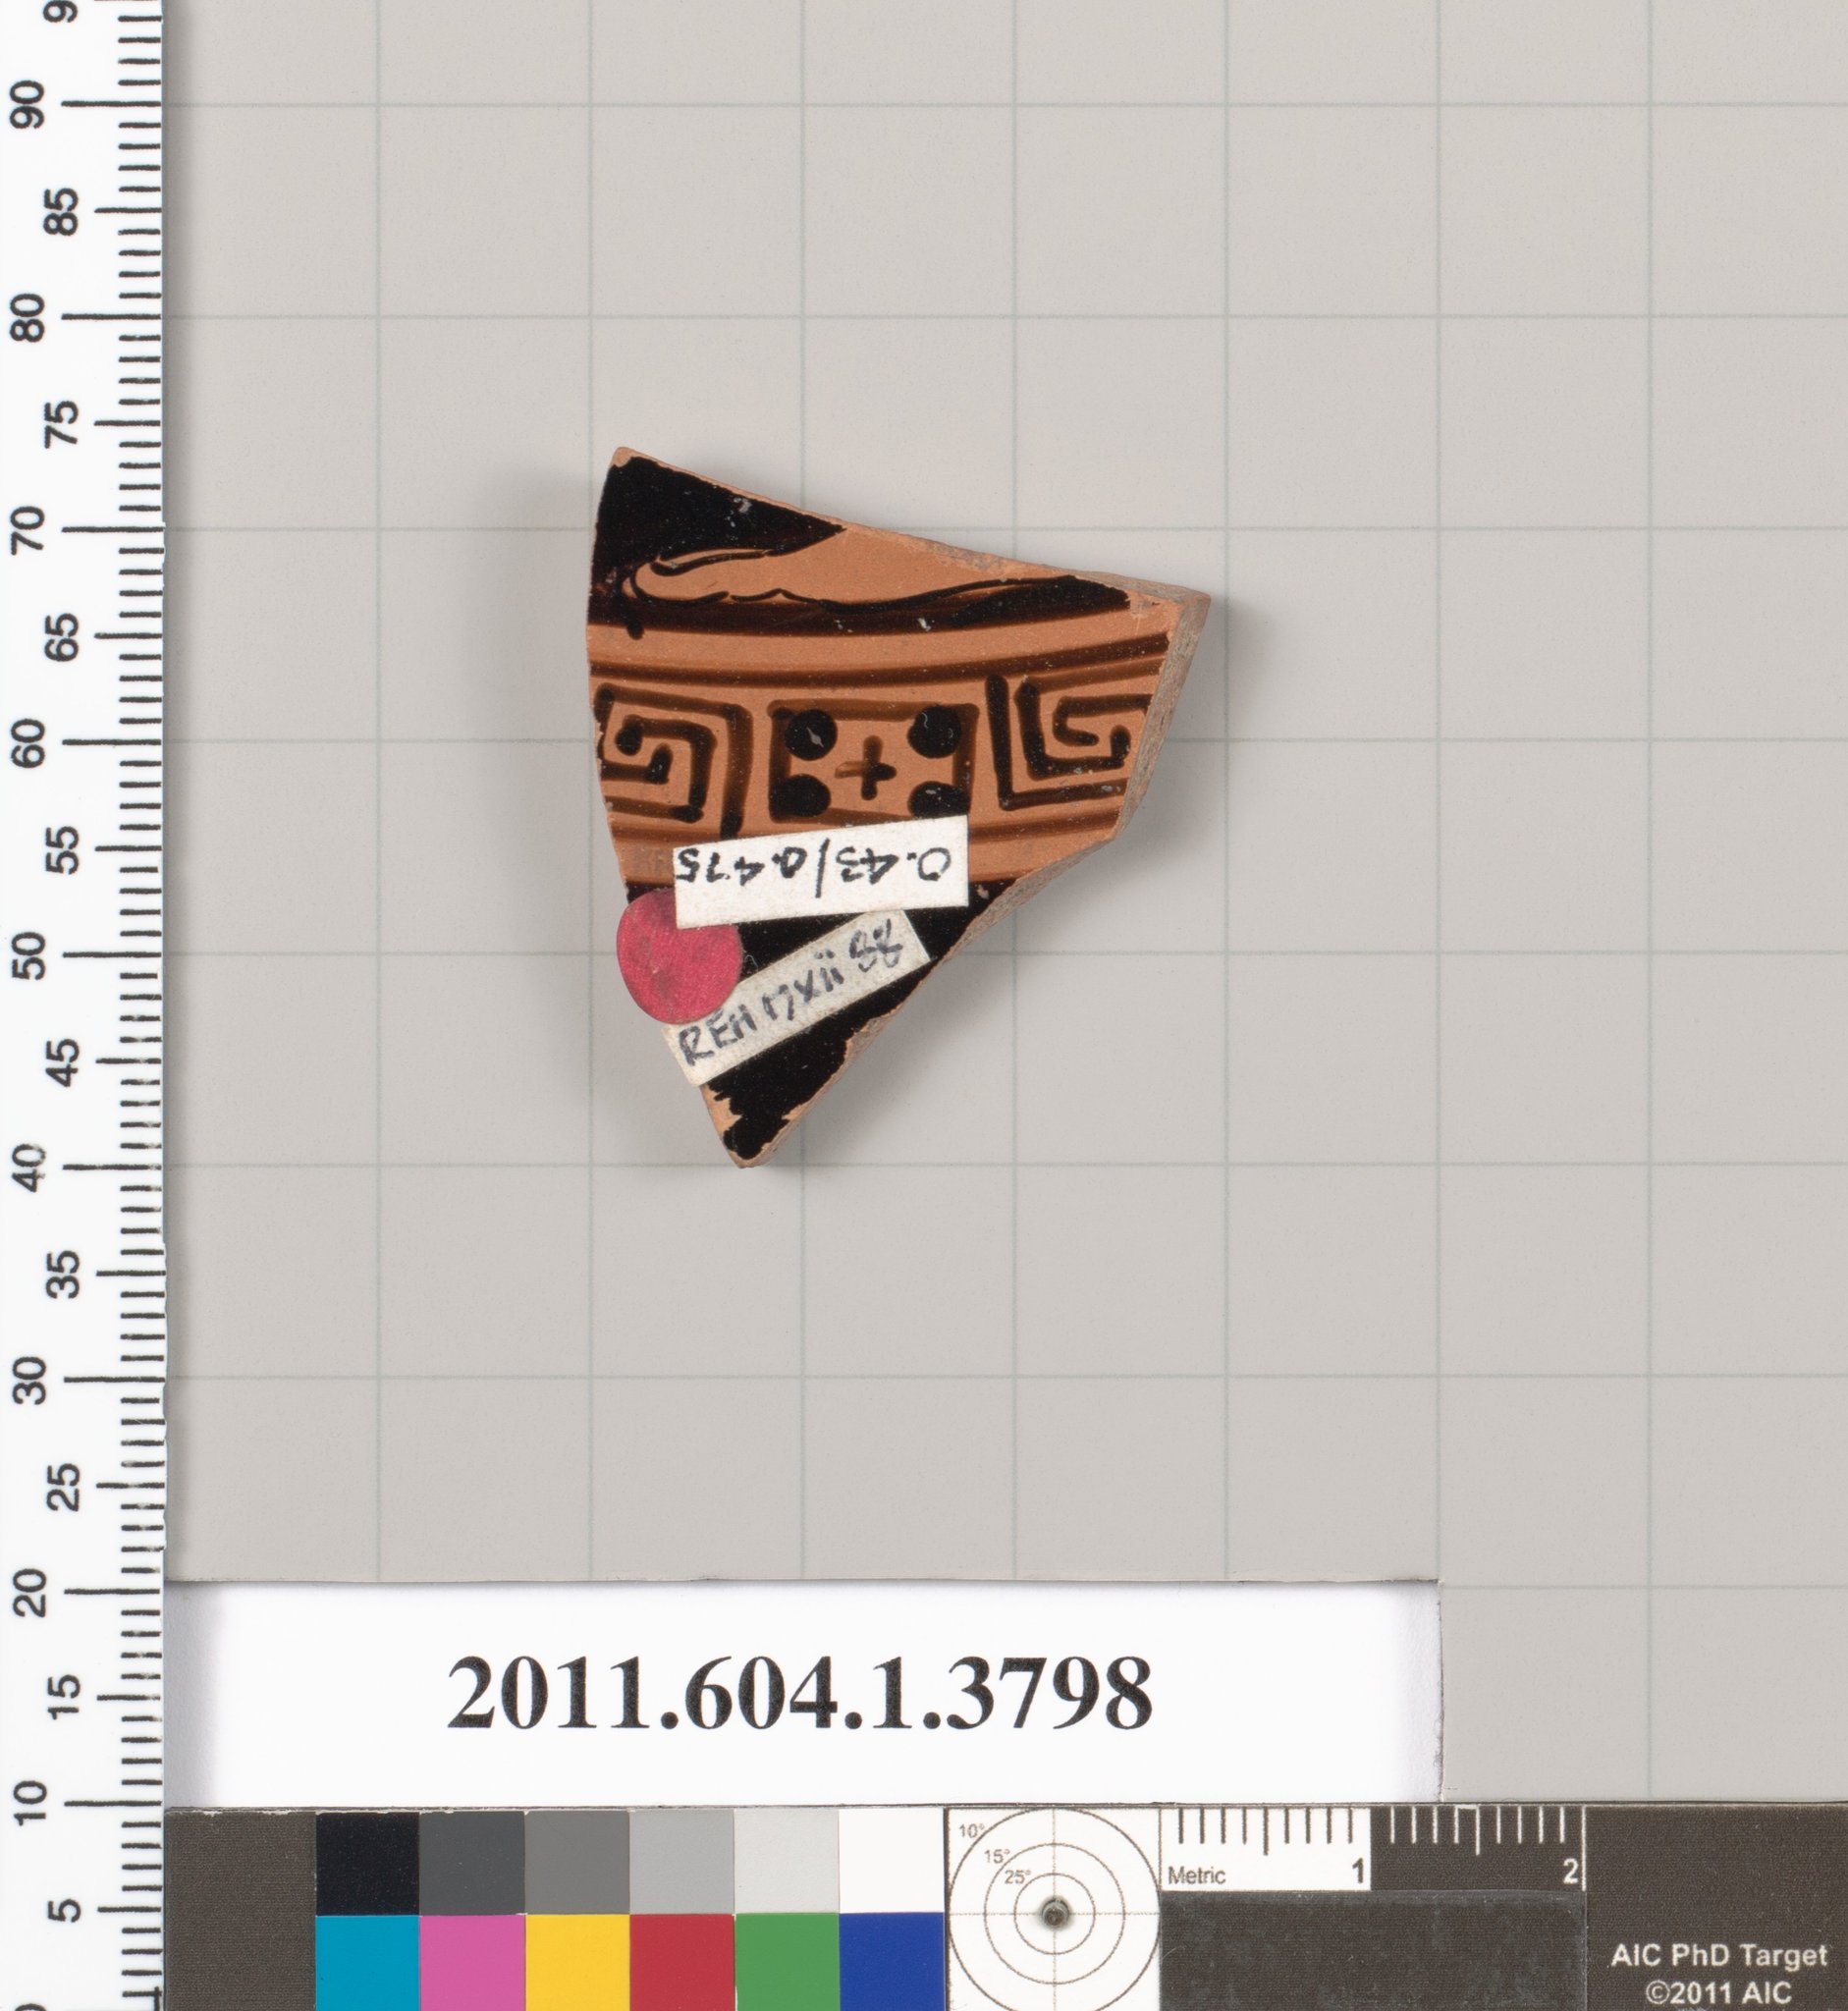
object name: kylix fragment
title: Terracotta fragment of a kylix (drinking cup)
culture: greek, attic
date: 490-470 BCE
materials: terracotta